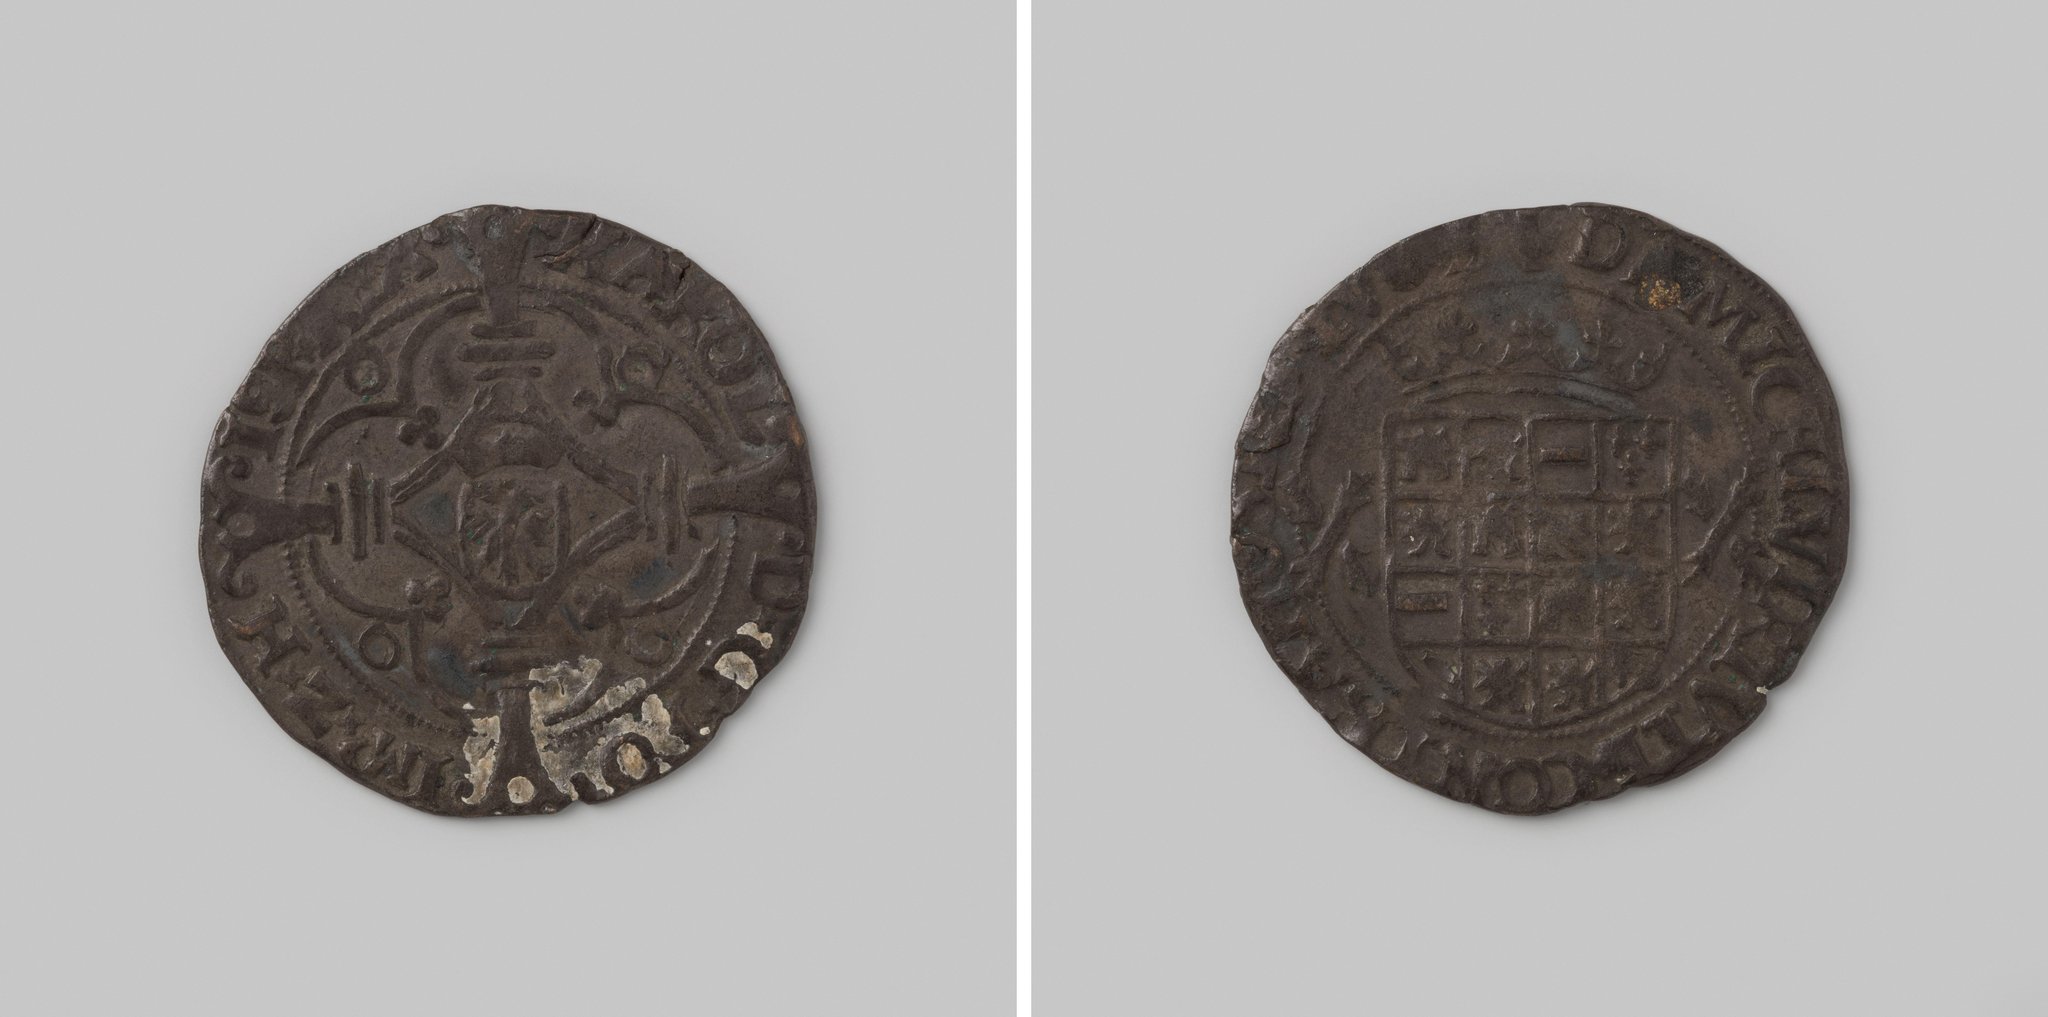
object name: coin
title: Brabant, Karel V, stuiver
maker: charles v (holy roman emperor and king of spain)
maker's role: keizer, koning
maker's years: 1500-1558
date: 1521-1529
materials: silver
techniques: striking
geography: antwerp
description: Voorzijde: op een vierpas lang versierd kruis, in hart gekroond wapenschild van het Heilige Roomse Rijk. Keerzijde: tussen twee gekruiste knoestige stokken gekroond wapenschild van Oostenrijk-Bourgondië. Boven kroon in omschrift hand [=Antwerpen]